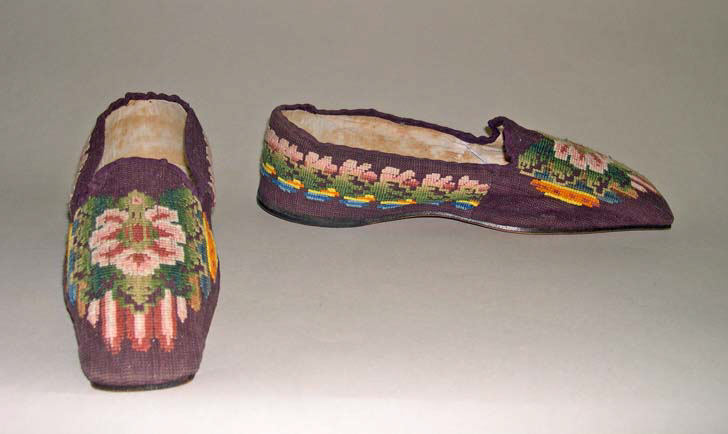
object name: slipper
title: Slippers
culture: american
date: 1834-1866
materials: leather, silk